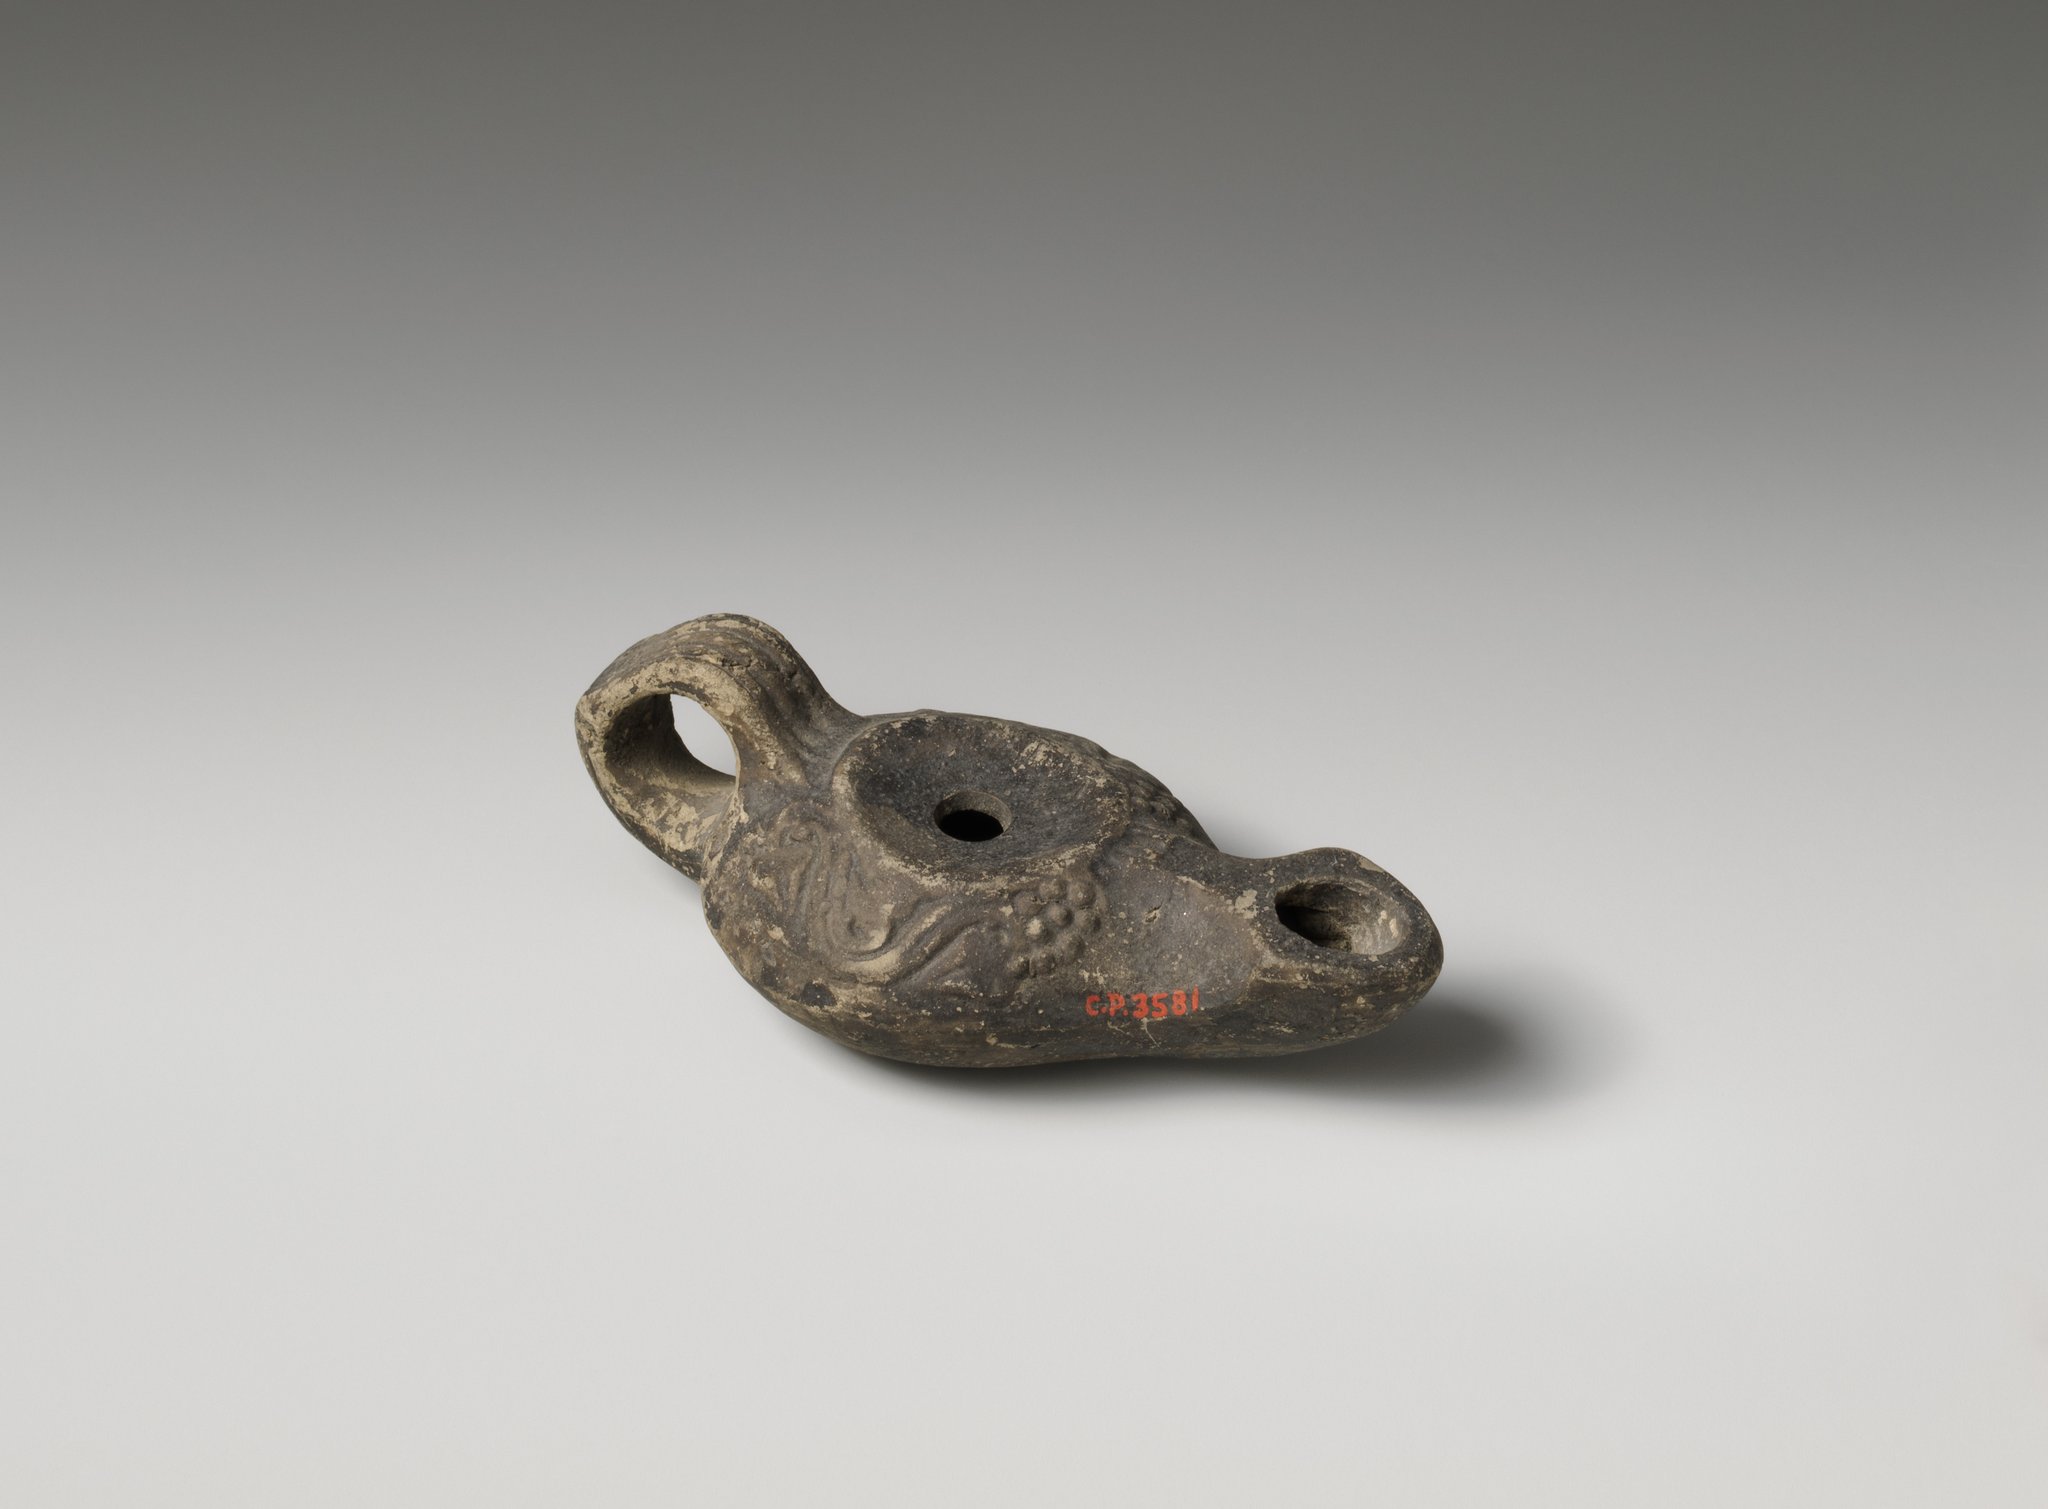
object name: lamp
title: Terracotta oil lamp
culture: greek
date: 100-1 BCE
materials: terracotta